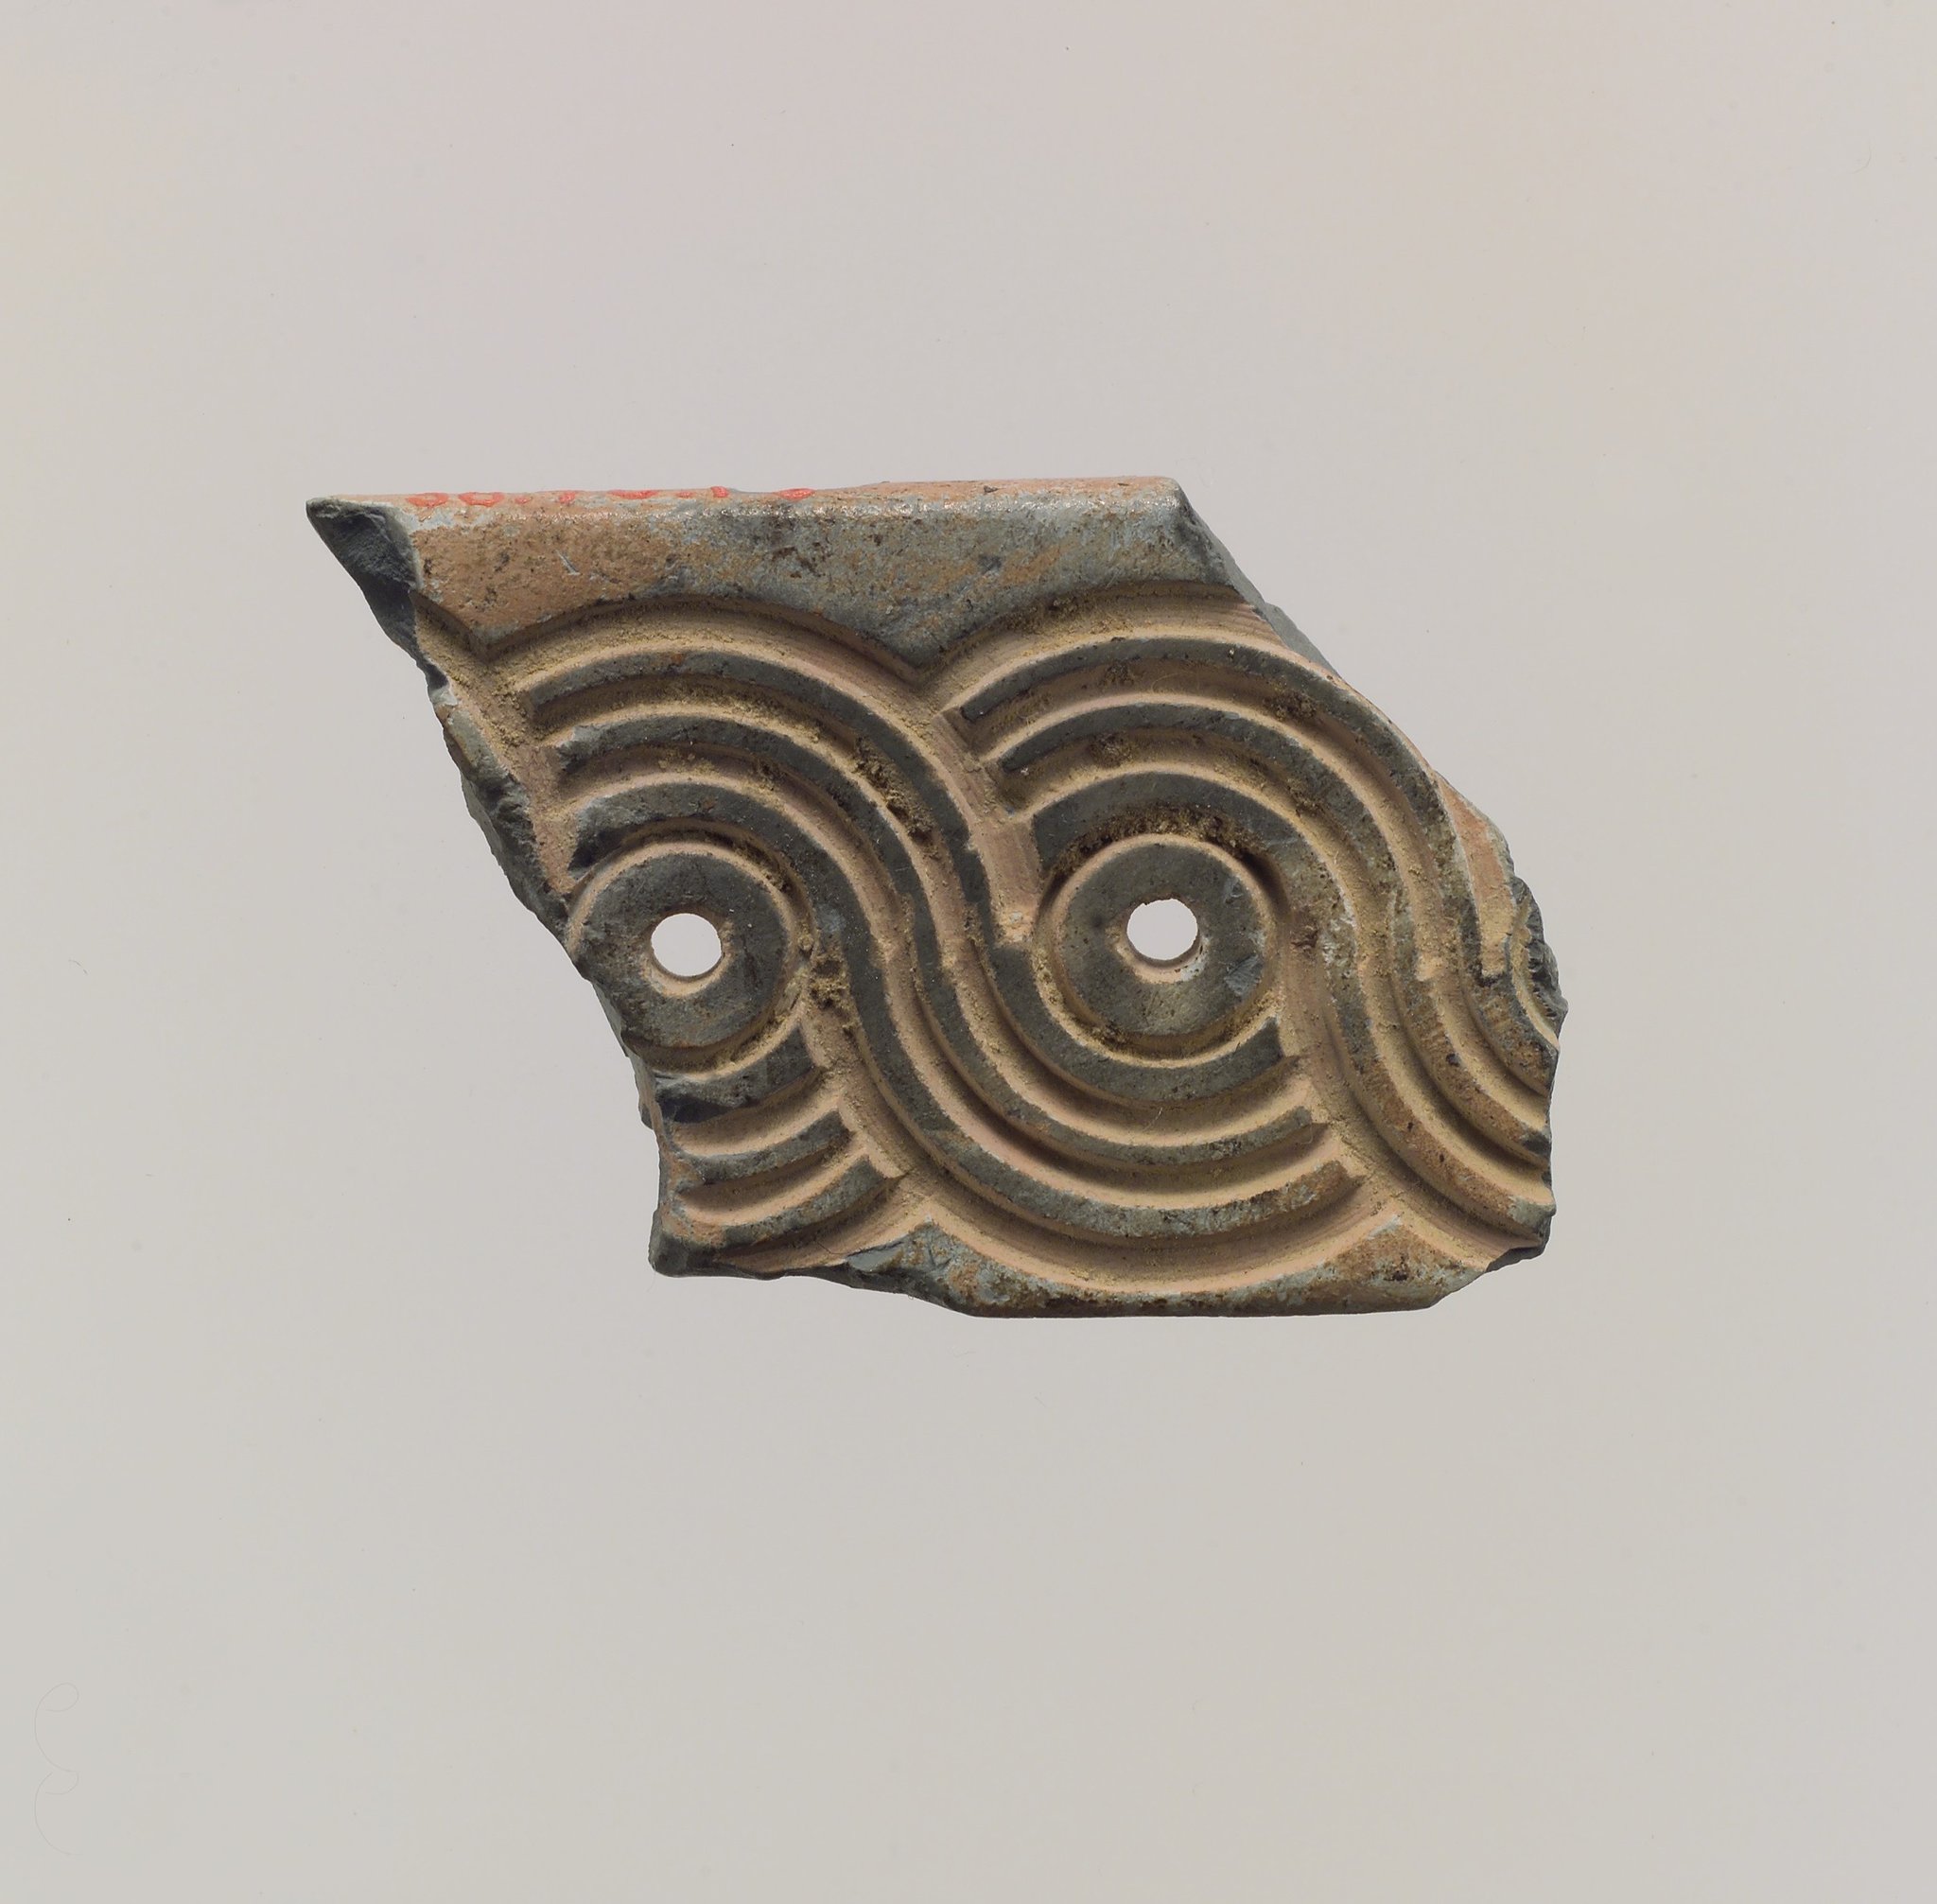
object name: relief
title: Plaque fragment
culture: assyrian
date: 1800-1701 BCE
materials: ivory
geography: anatolia